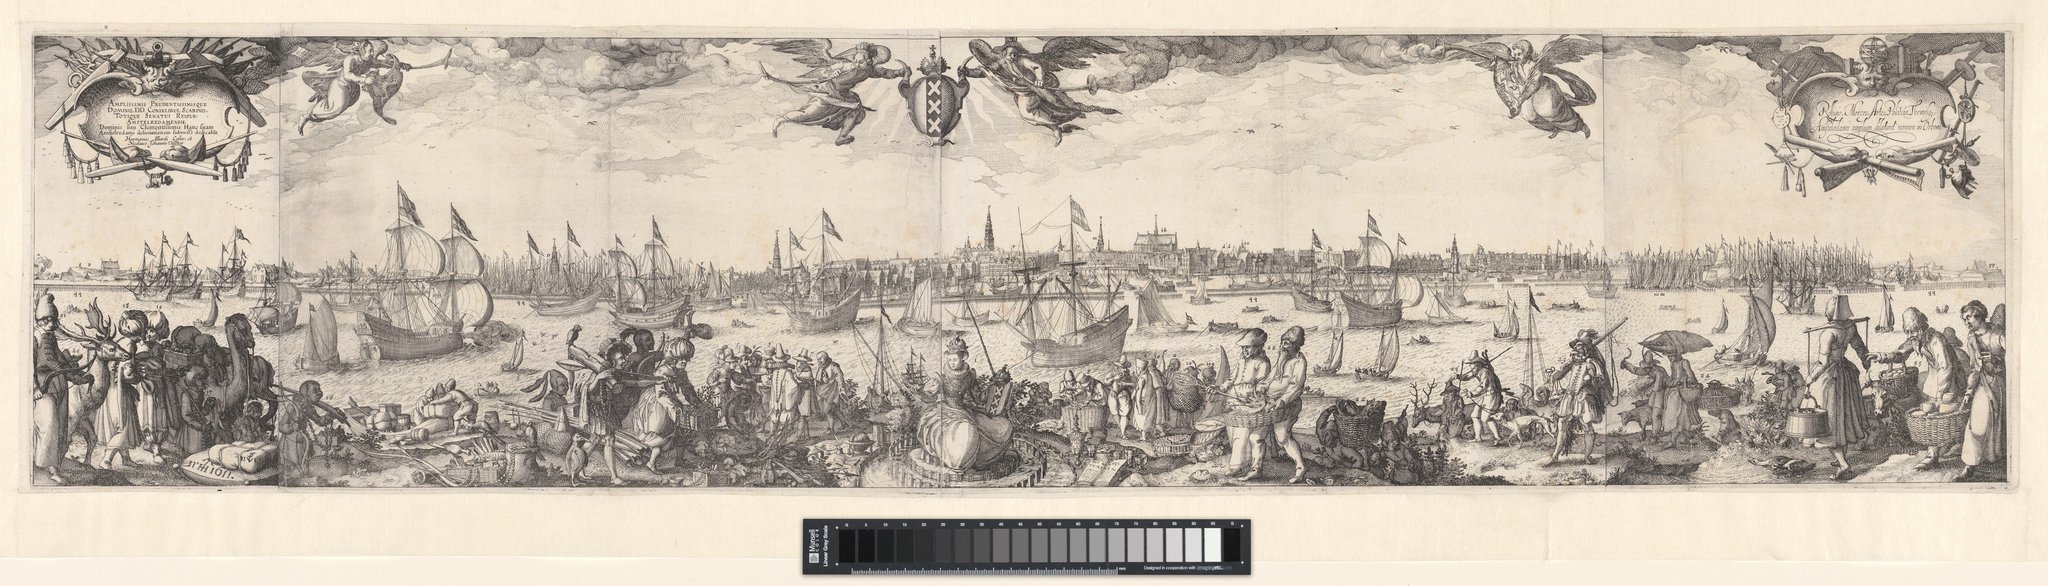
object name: print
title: A View of Amsterdam from the north Bank of the IJ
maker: claes jansz. visscher (ii)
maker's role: artist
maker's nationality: dutch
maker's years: 1586-1652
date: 1611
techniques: engraving, etching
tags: cities,rivers,coat of arms,boats,amsterdam